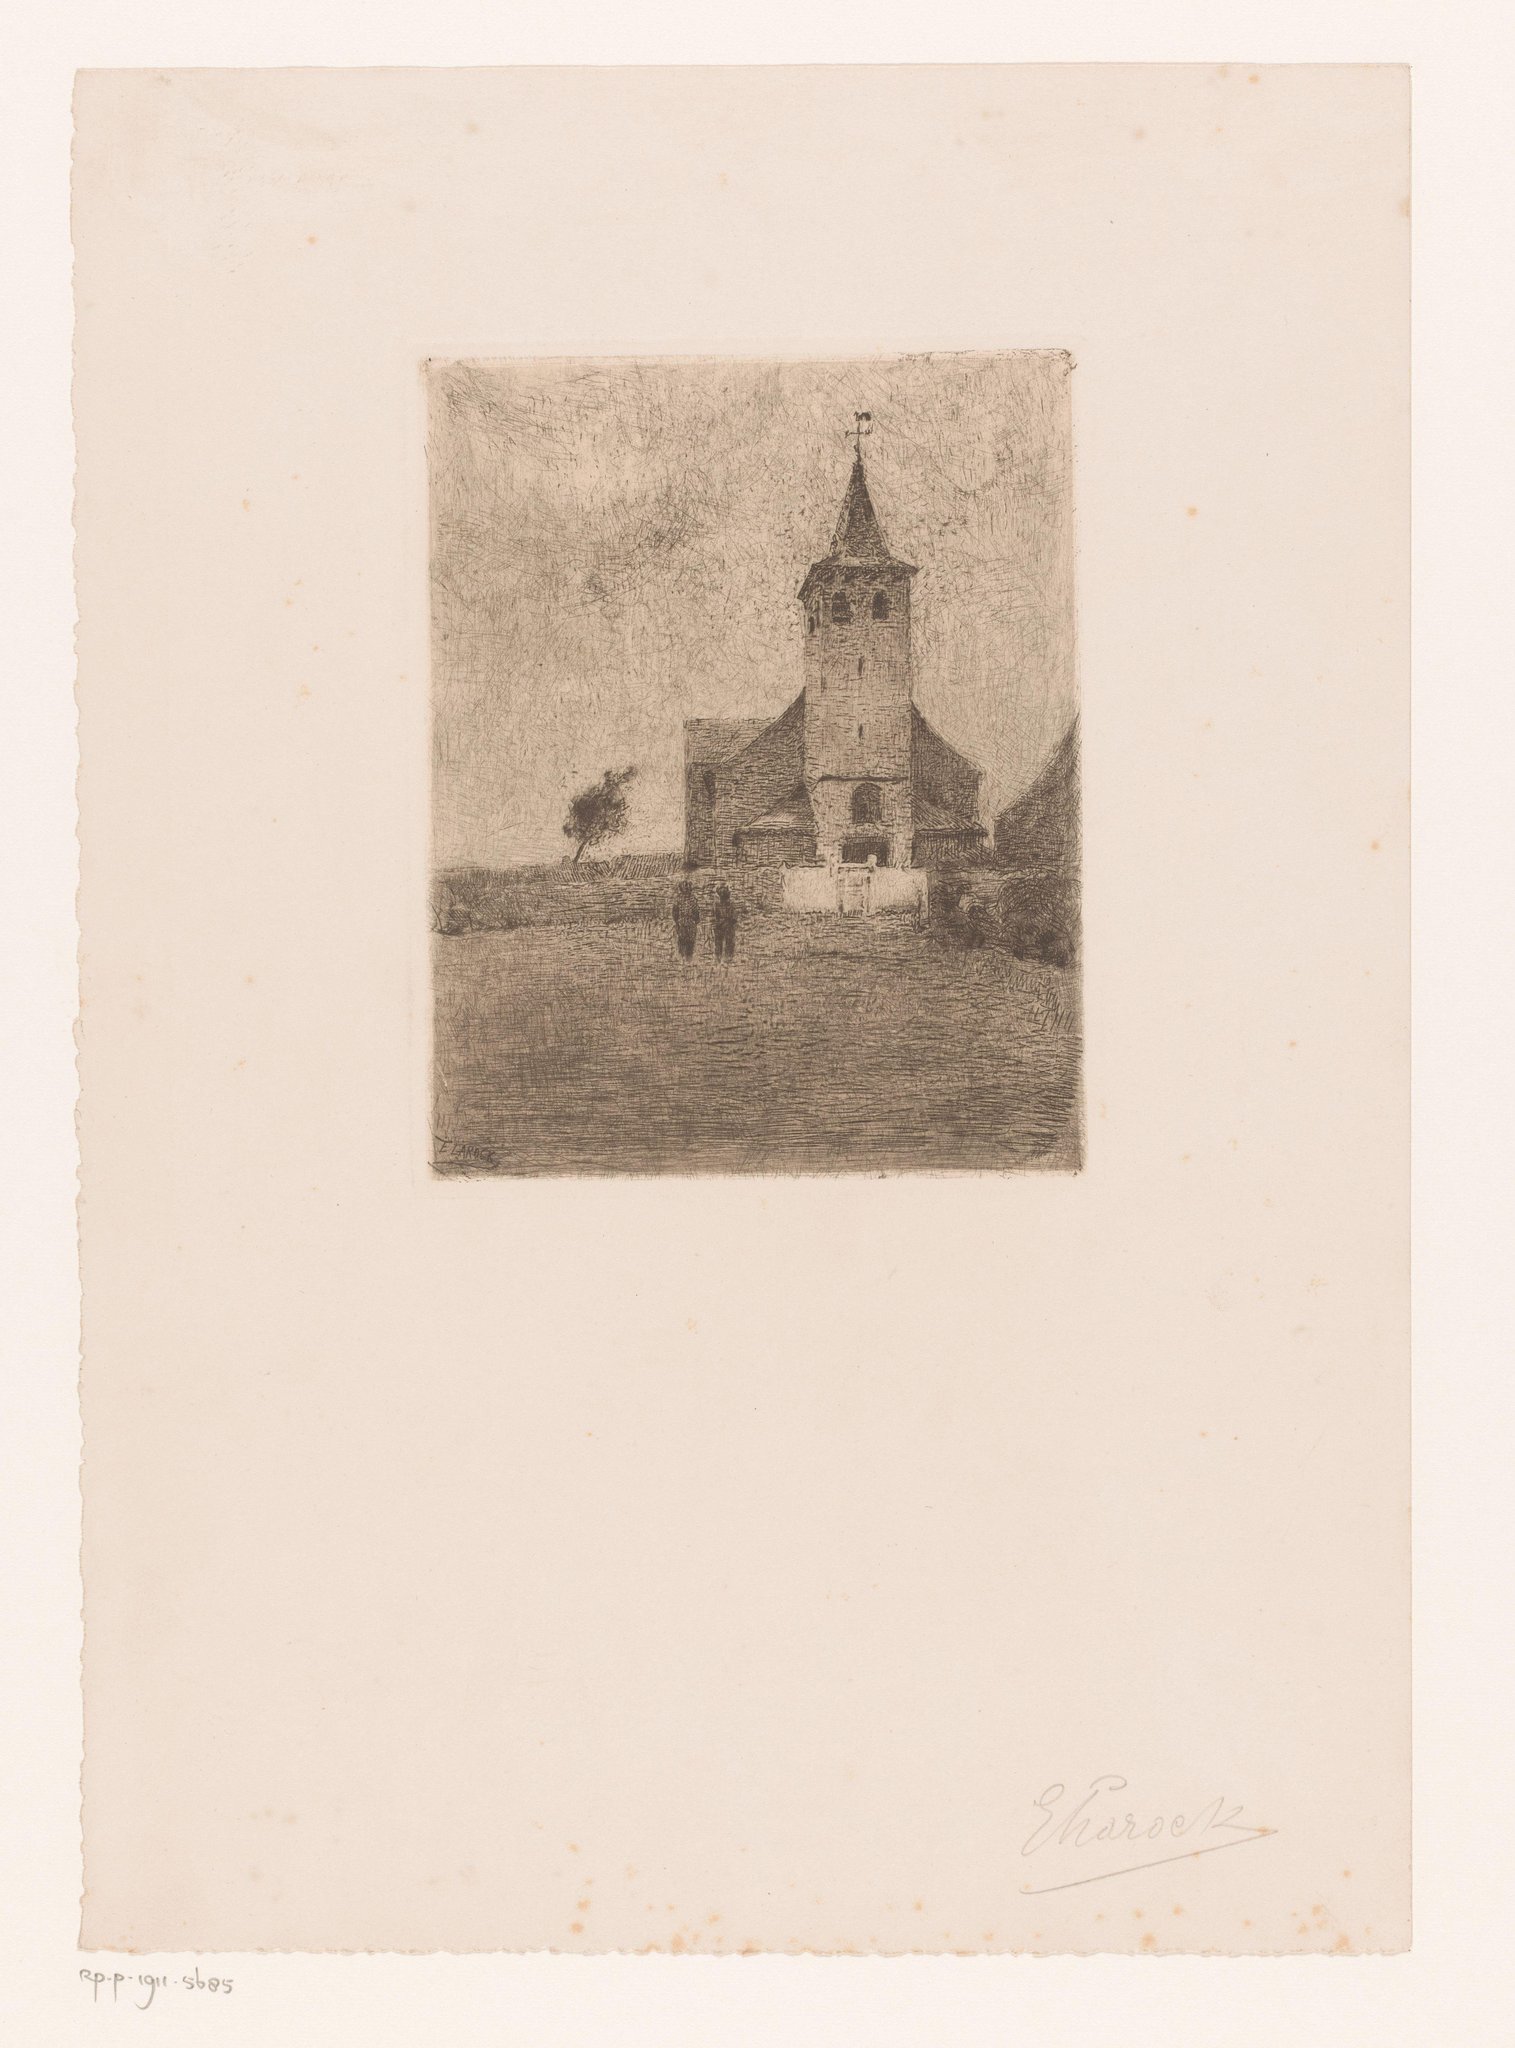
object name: print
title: Gezicht op een kerk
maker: evert larock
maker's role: print maker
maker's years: 1865-1901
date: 1875-1901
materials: paper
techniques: etching, intaglio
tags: church (exterior)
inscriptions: collector's mark: Lugt 2228